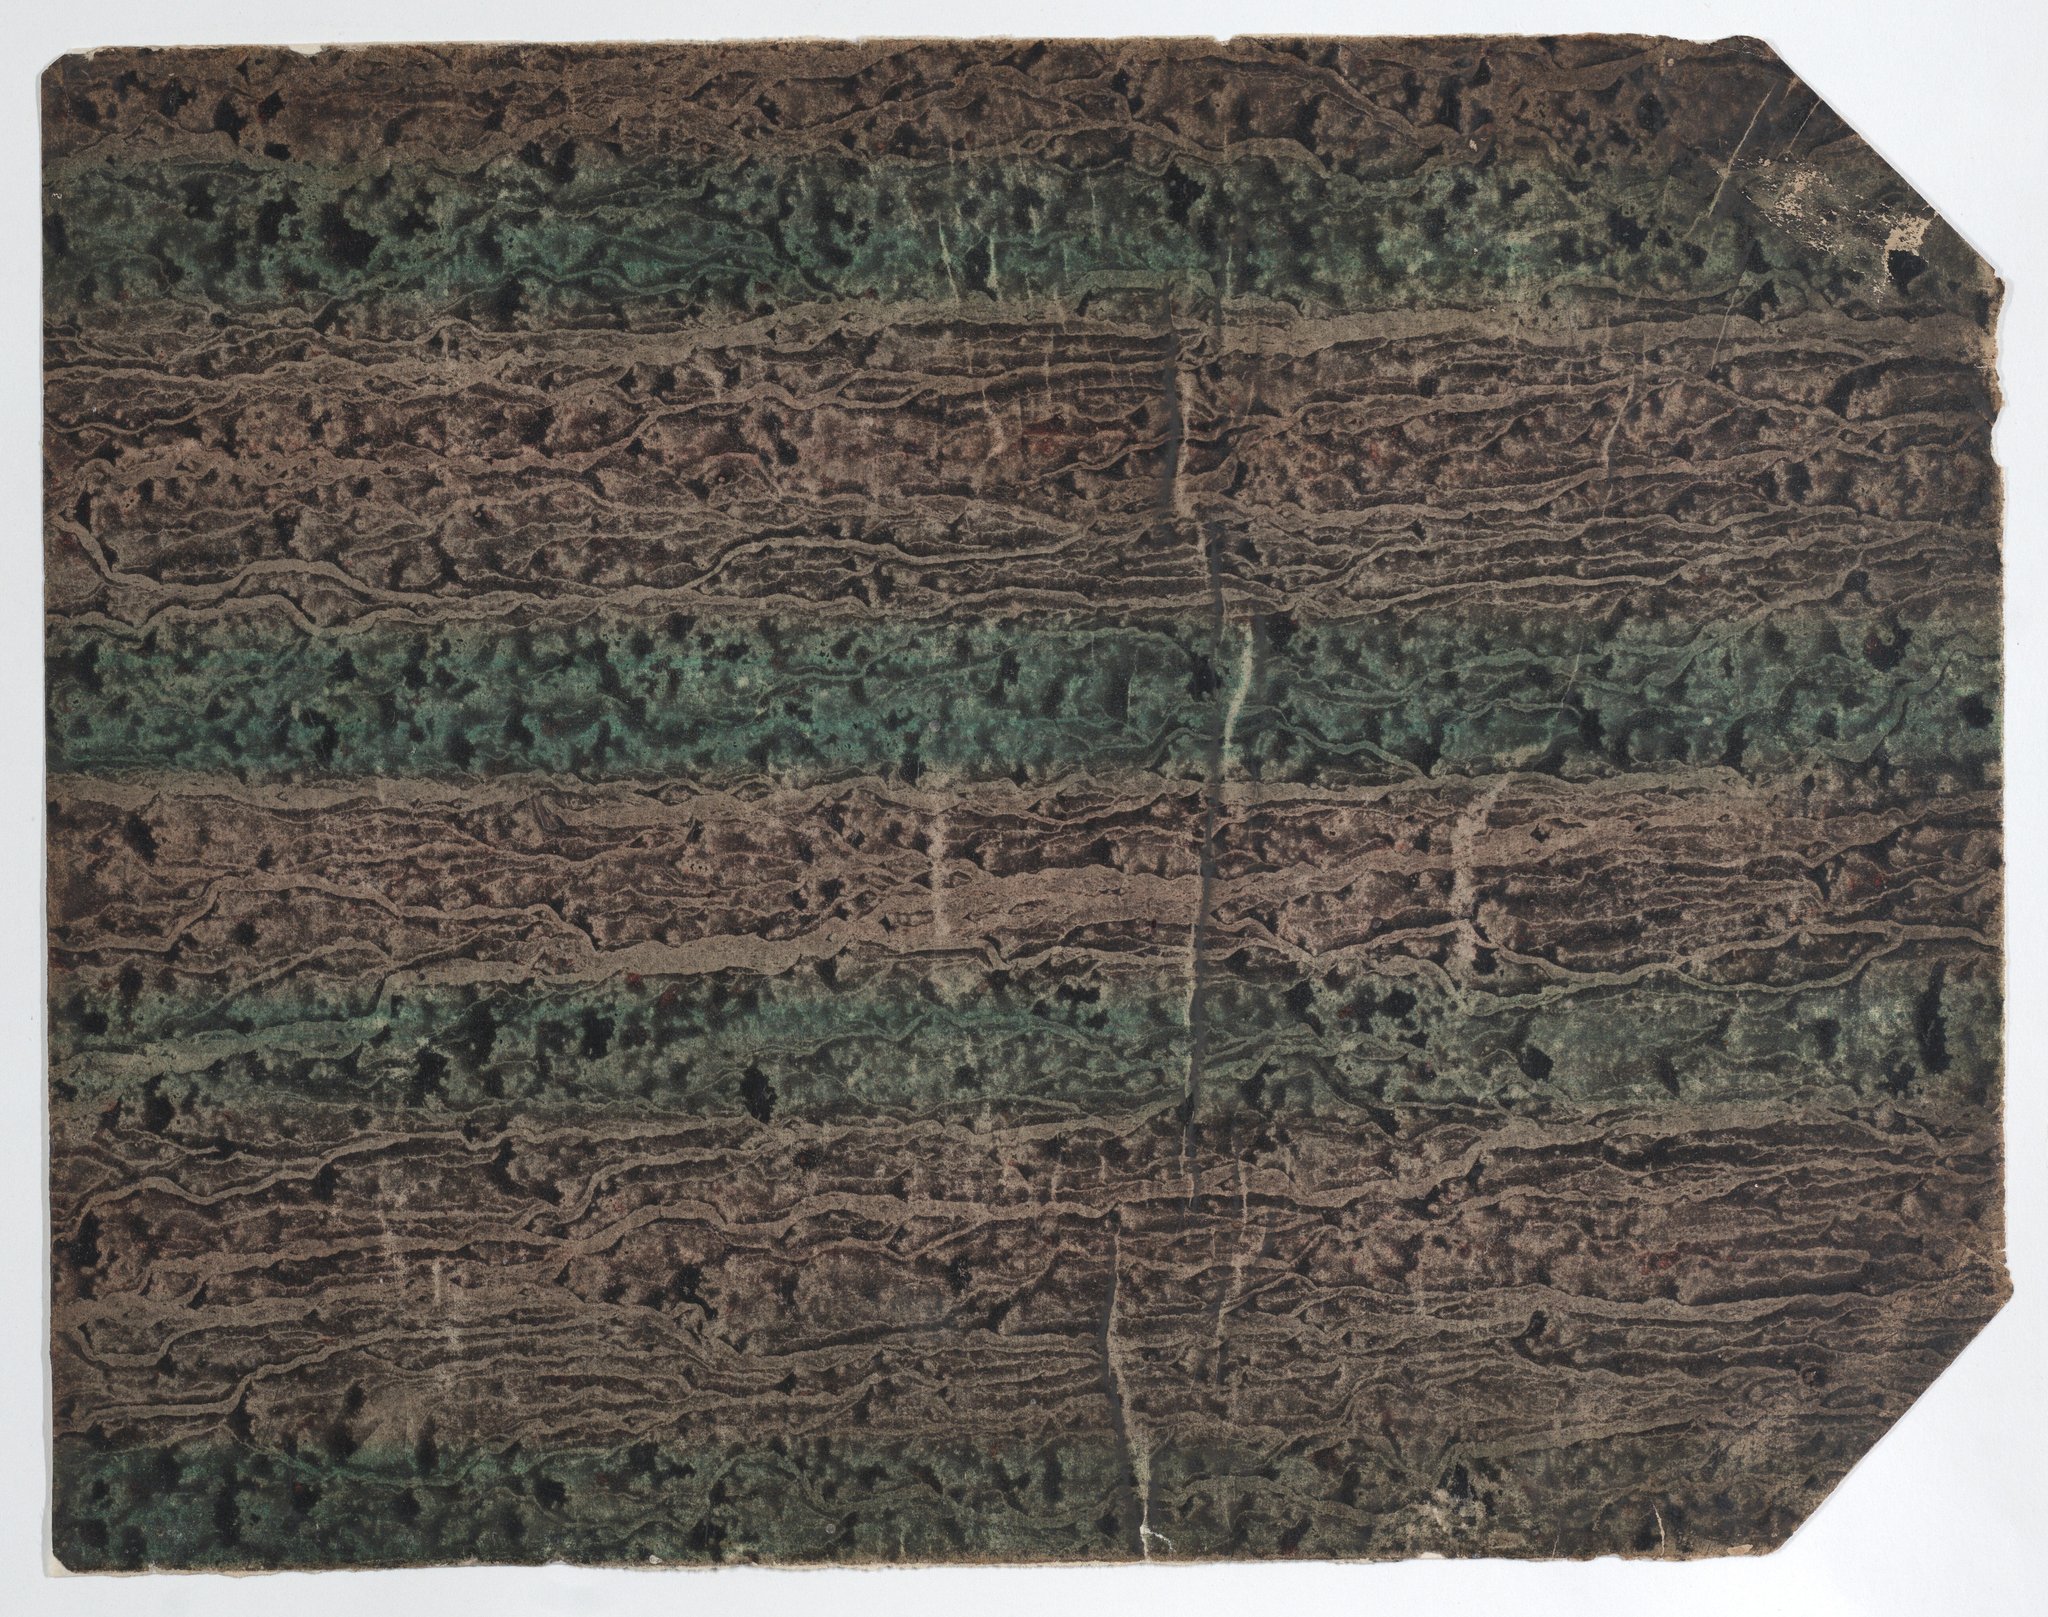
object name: book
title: Die Conditorei im Bildern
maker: conrad wegner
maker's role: author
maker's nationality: german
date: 1854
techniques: hand coloring, lithograph